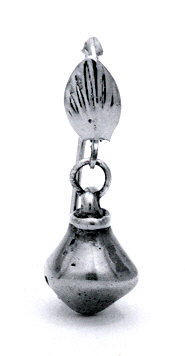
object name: ornament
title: Pendant Bell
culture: costa rican or panamanian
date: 701-1600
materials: gold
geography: costa rica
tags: musical instruments